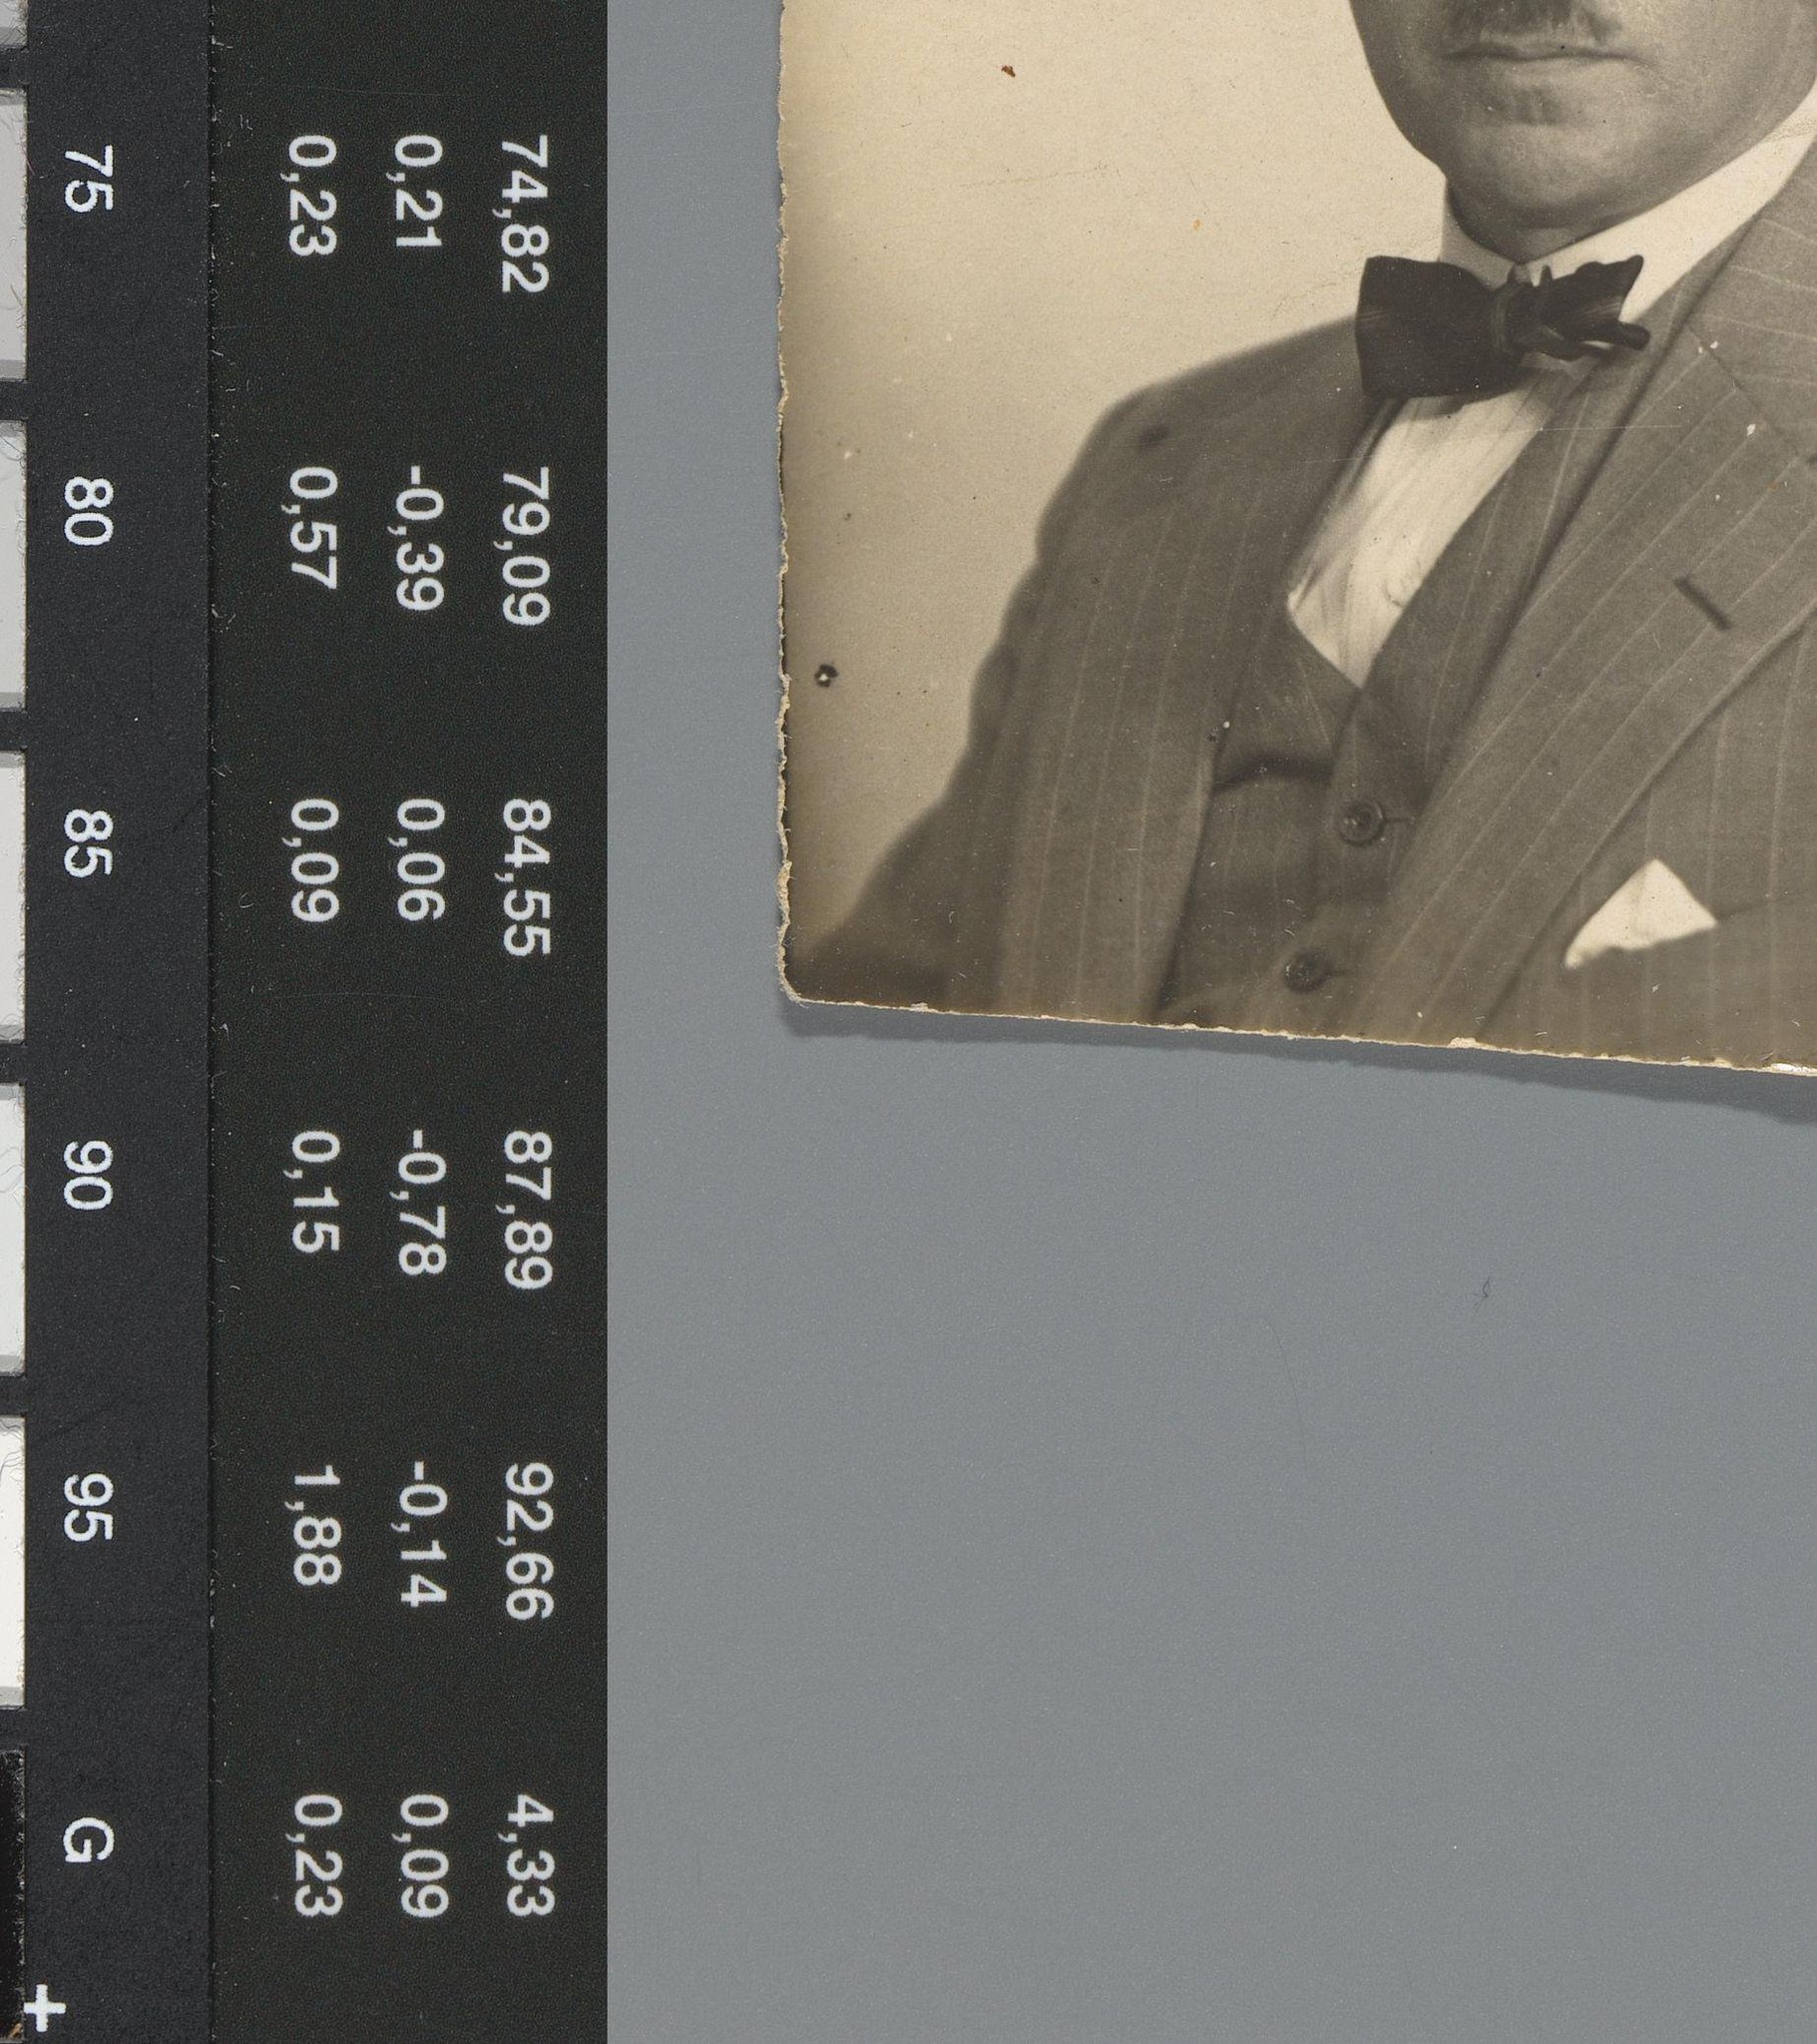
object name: passport photograph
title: Pasfoto van Hendrik Herman van den Berg (Henk)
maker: Anonymous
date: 1923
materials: cardboard, photographic support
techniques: photography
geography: netherlands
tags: batavia, hendrik herman van den berg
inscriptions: inscription: ‘pasfoto / 1923’